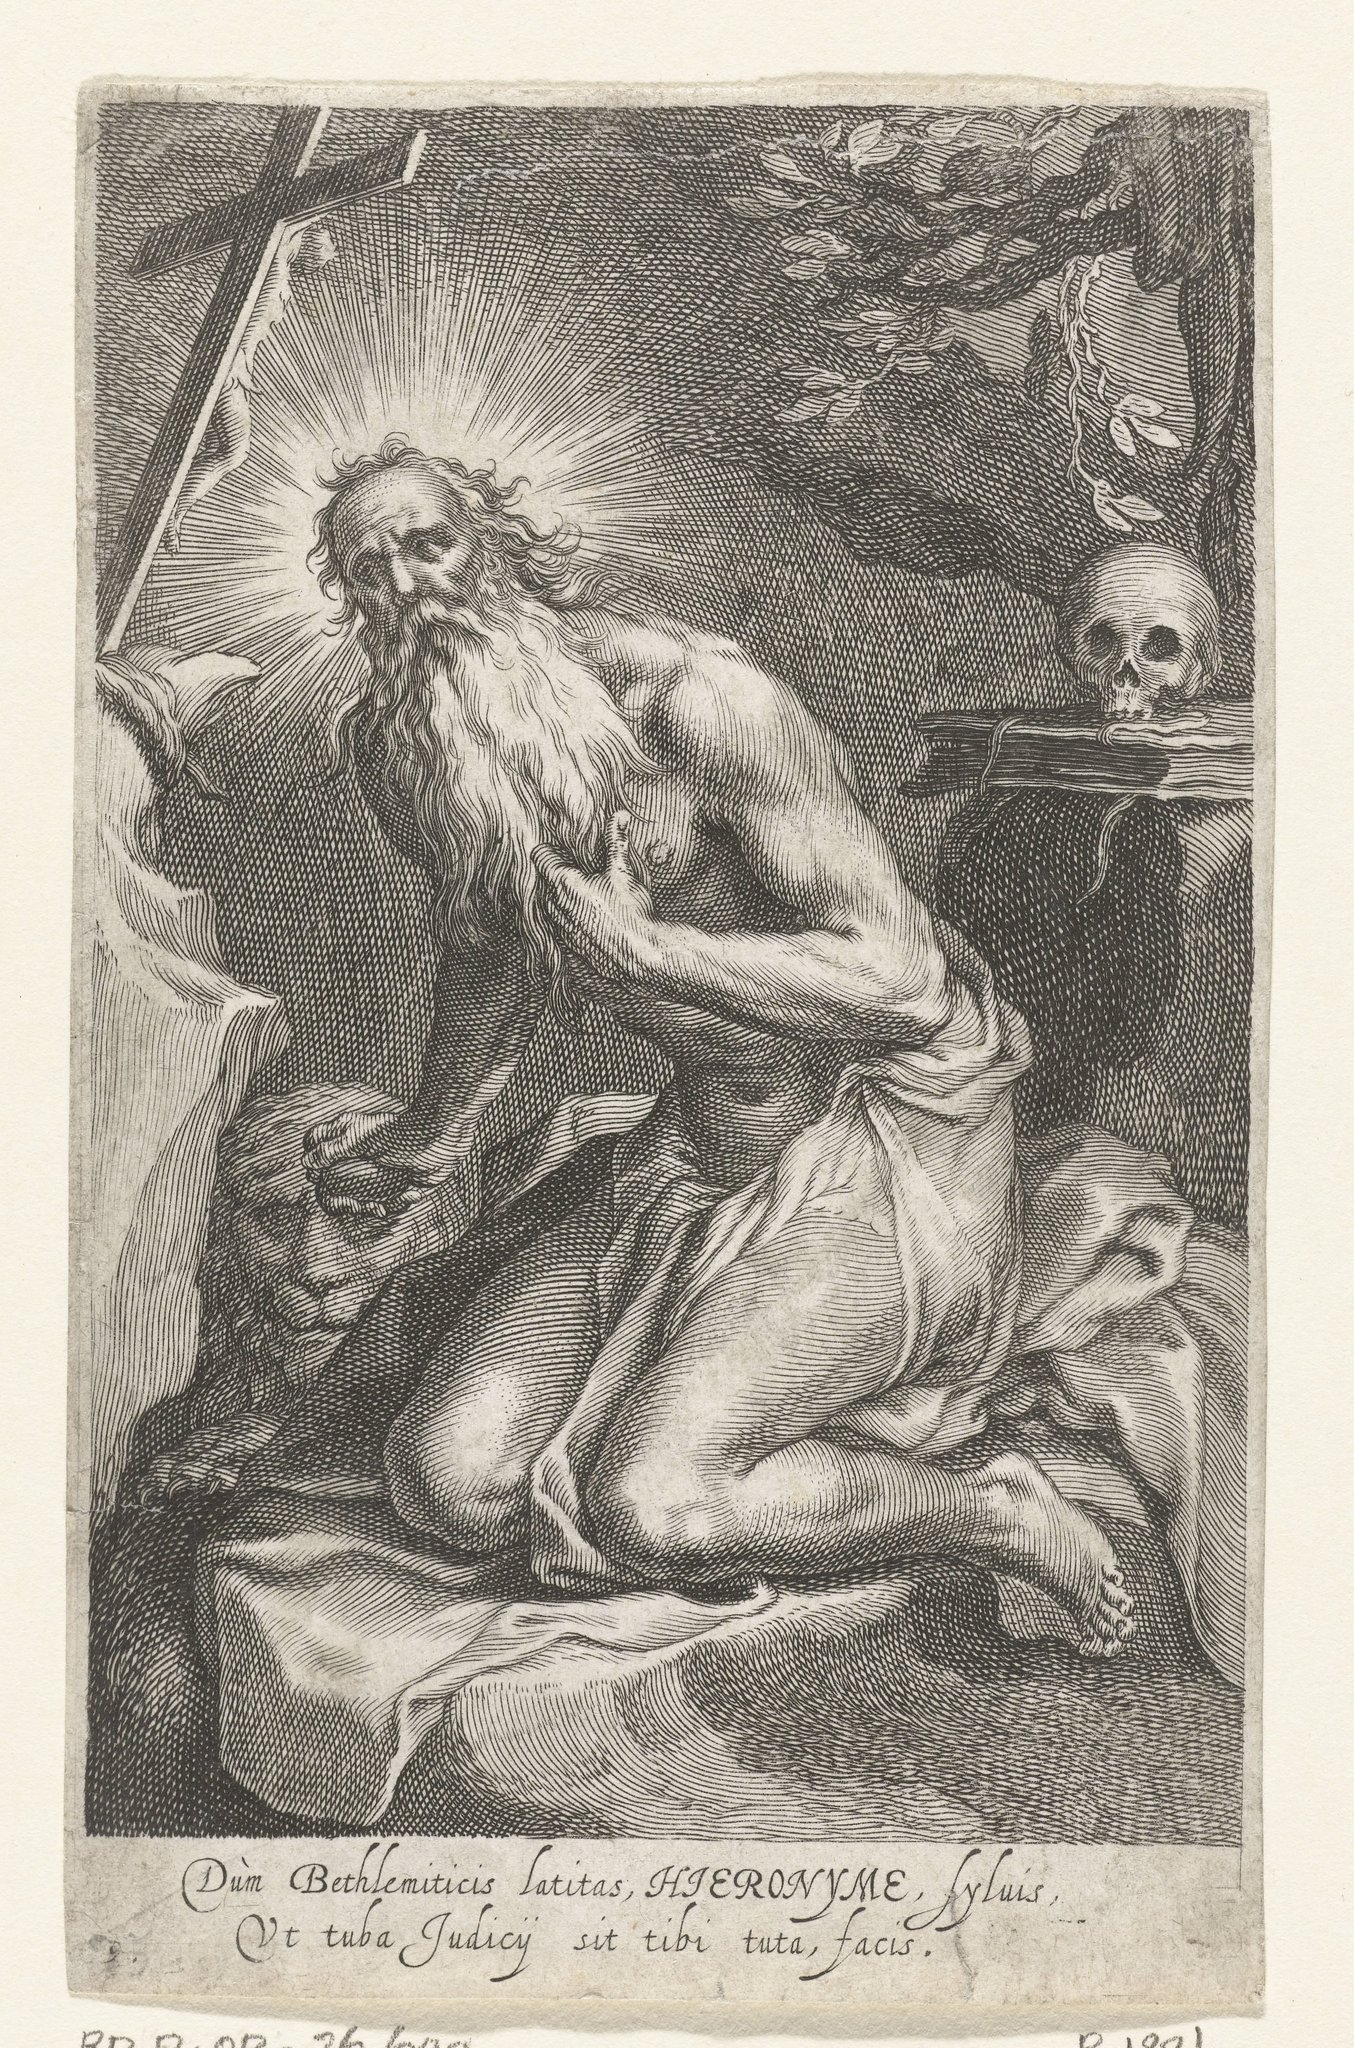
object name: book illustration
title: Heilige Hiëronymus van Betlehem als kluizenaar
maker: boëtius adamsz. bolswert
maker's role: print maker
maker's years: 1580-1633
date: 1590-1612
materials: paper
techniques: engraving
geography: low countries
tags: st. jerome as penitent in the desert, half naked, kneeling before a crucifix and holding a stone in his hand to beat his breast; a skull (and other 'vanitas' symbols), sometimes a scorpion and a snake beside him, anchorite, hermit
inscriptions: collector's mark: Lugt 2228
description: Prent uit: Ad sacrum speculum recurris? ... patribus dat ales, geen plaats, Boëtius Adamsz. Bolswert, 1612. Tweede ongebonden uitgave met in totaal vijftig prenten. Prent uit serie van drieentwintig mannelijke kluizenaars. In 1619 verscheen een gebonden editie maar op basis van de gewijzigde opschriften en samenstelling wordt aangenomen dat deze prenten ook in 1612 of iets daarvoor gedrukt werden. Roethlisberger beschouwt de uitgave van 1619 als de eerste staat en de ongebonden editie van 1612 als de tweede staat (Roethlisberger 1993, p. 171, 172).